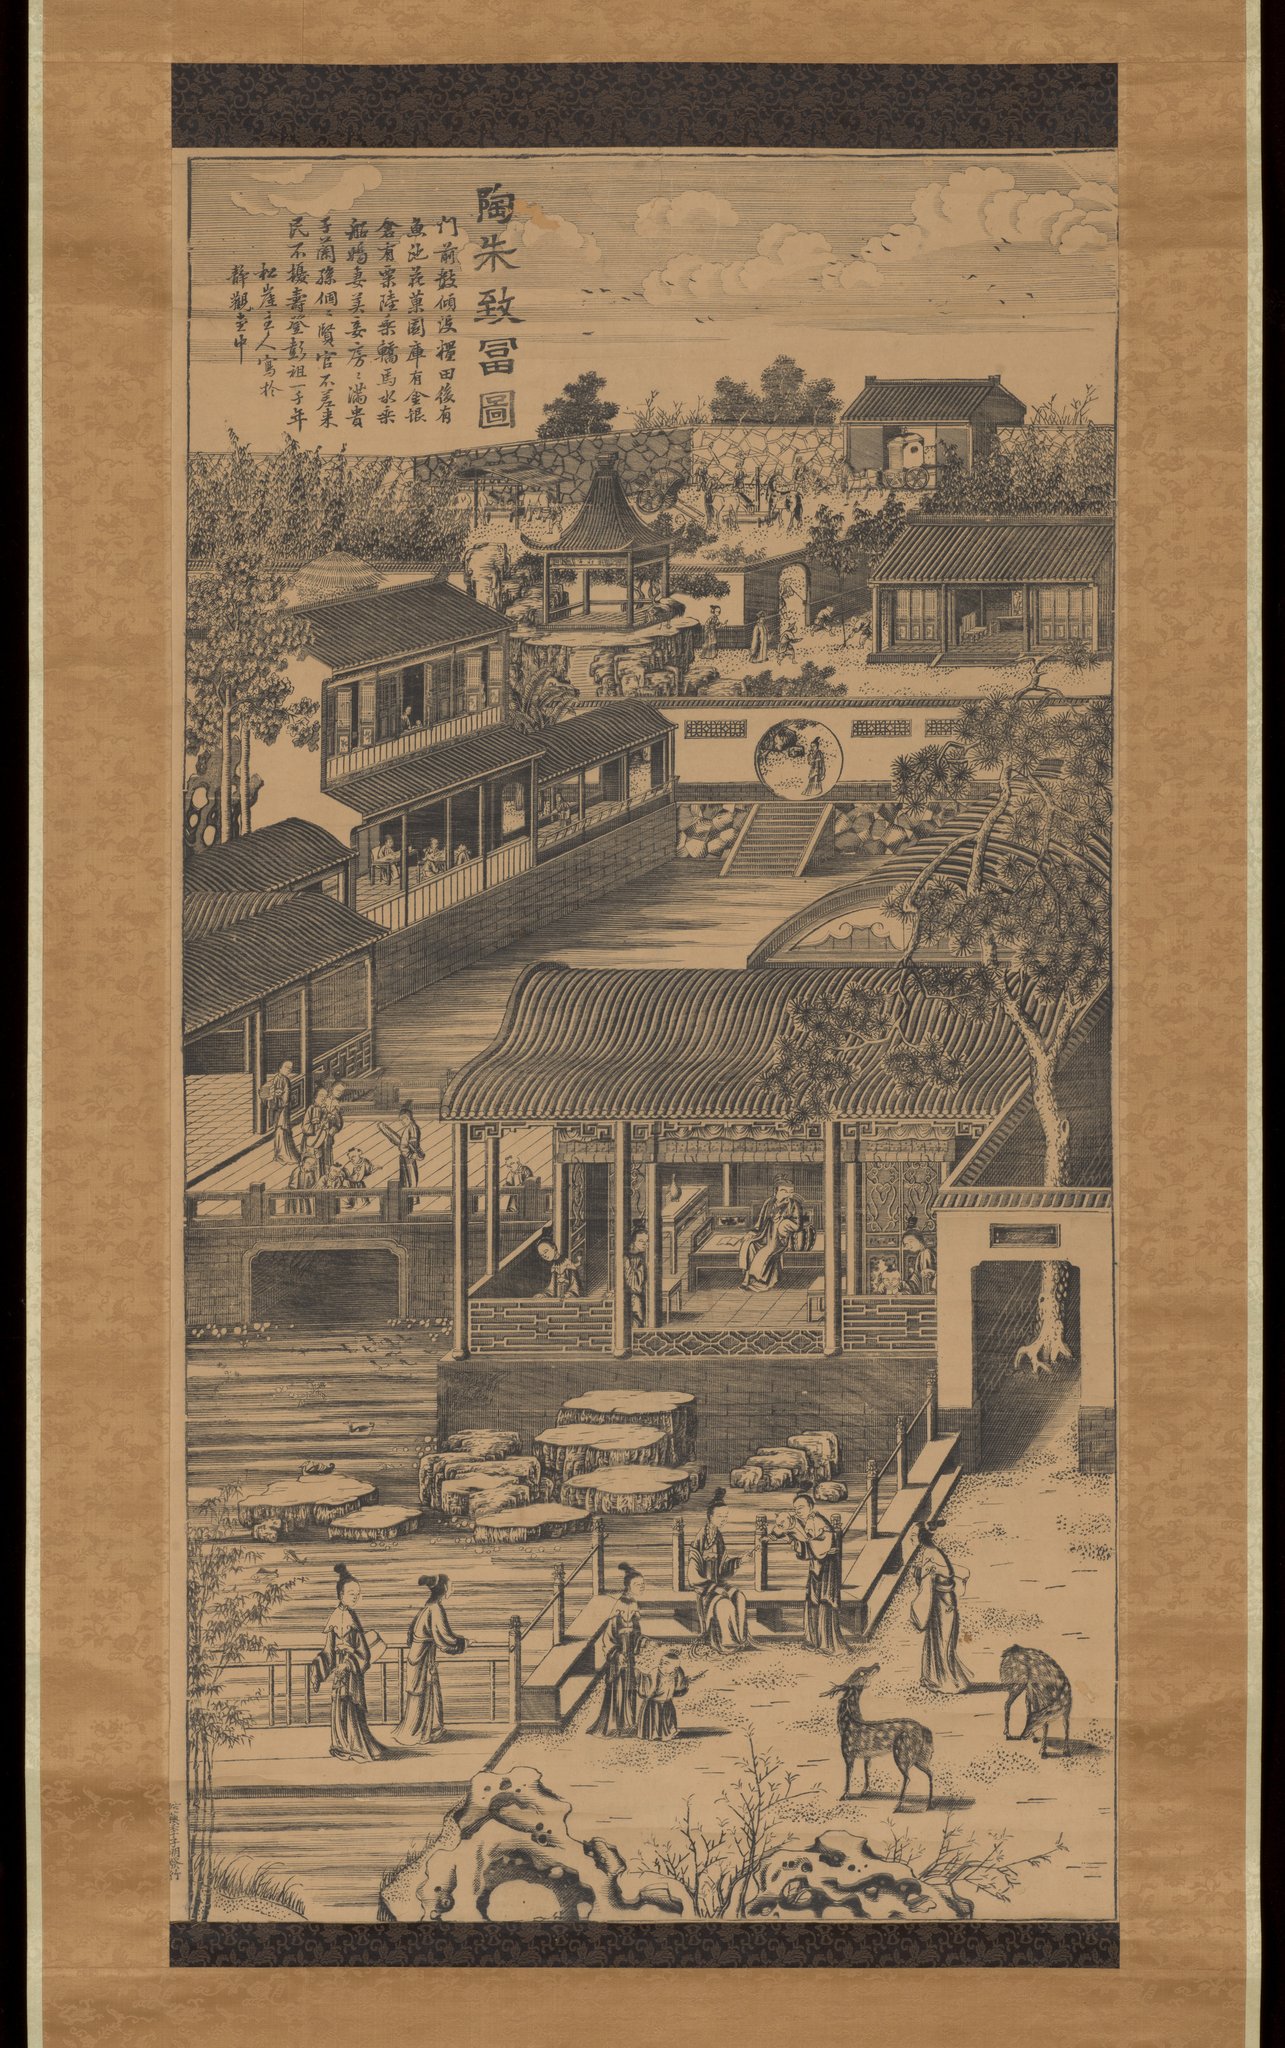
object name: print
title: Taozhu Brings Wealth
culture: chinese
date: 1736-1795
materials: ink, paper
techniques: woodblock print